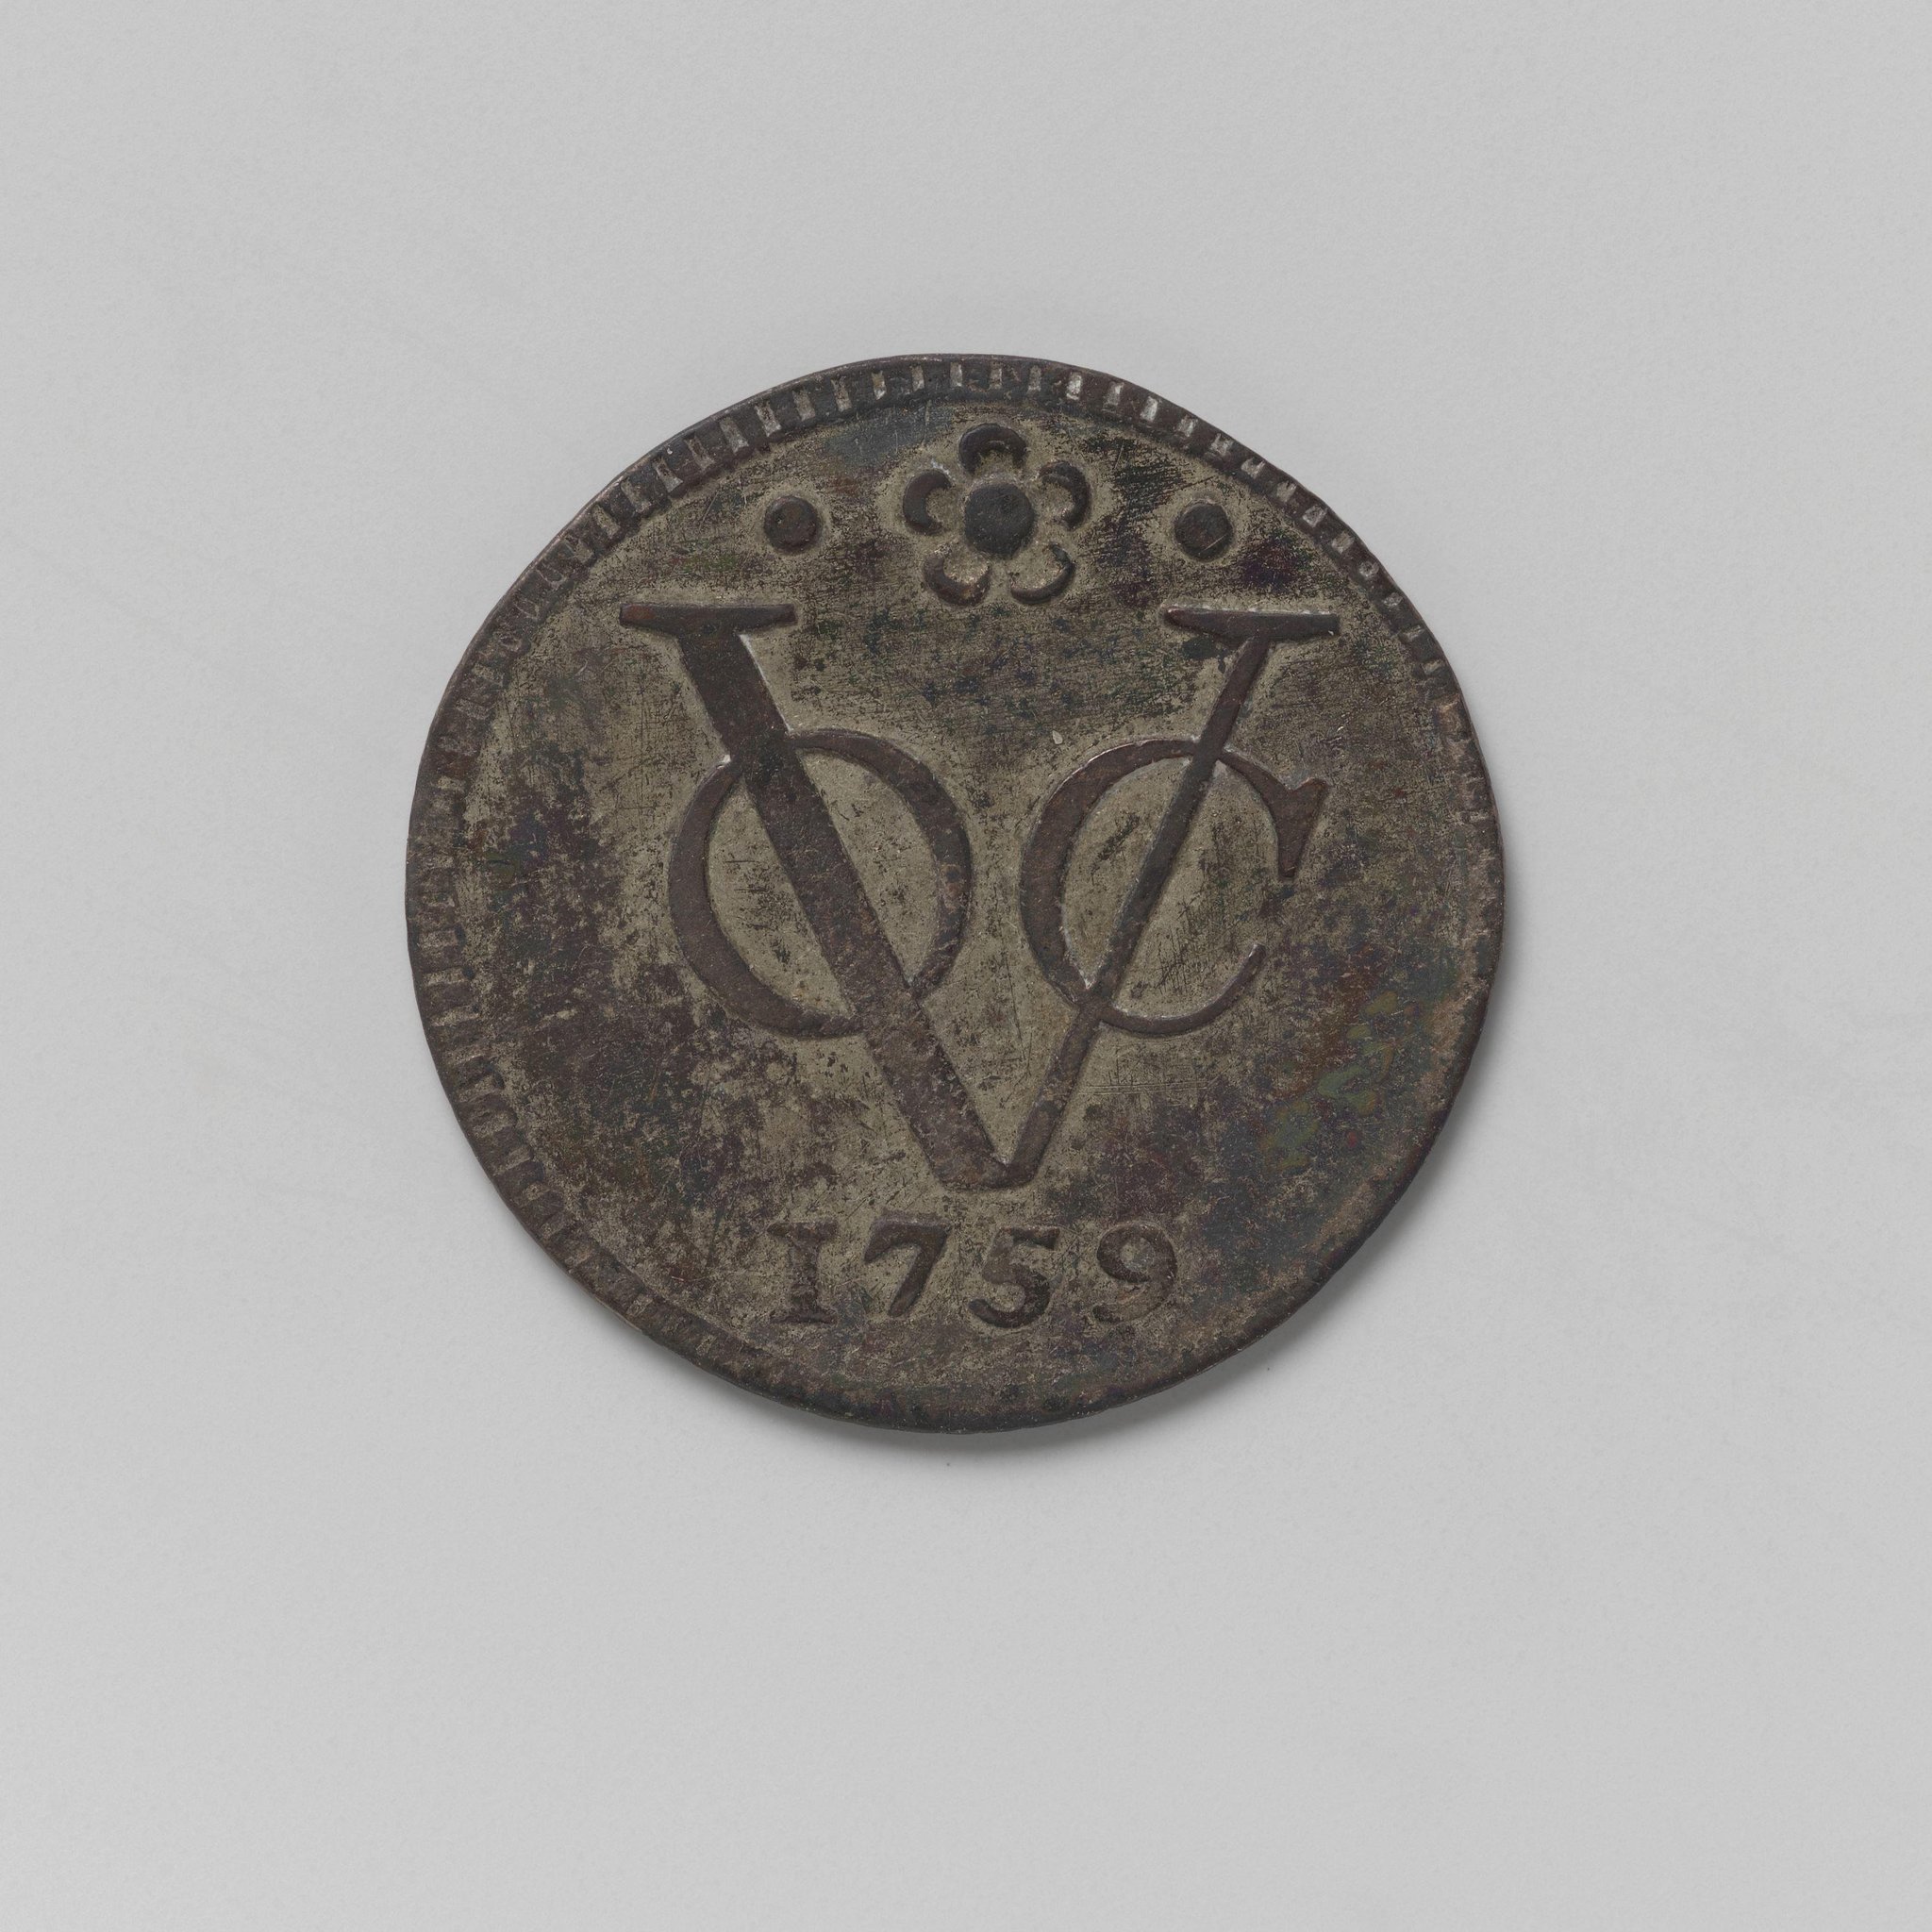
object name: coin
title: VOC, ½ duit Holland, 1759. Afslag in zilver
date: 1759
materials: silver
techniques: striking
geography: dordrecht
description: Zilveren munt. Voorzijde: gekroond wapenschild van Holland. Keerzijde: monogram van de VOC, waarboven muntteken en waaronder jaartal. Kabelrand.